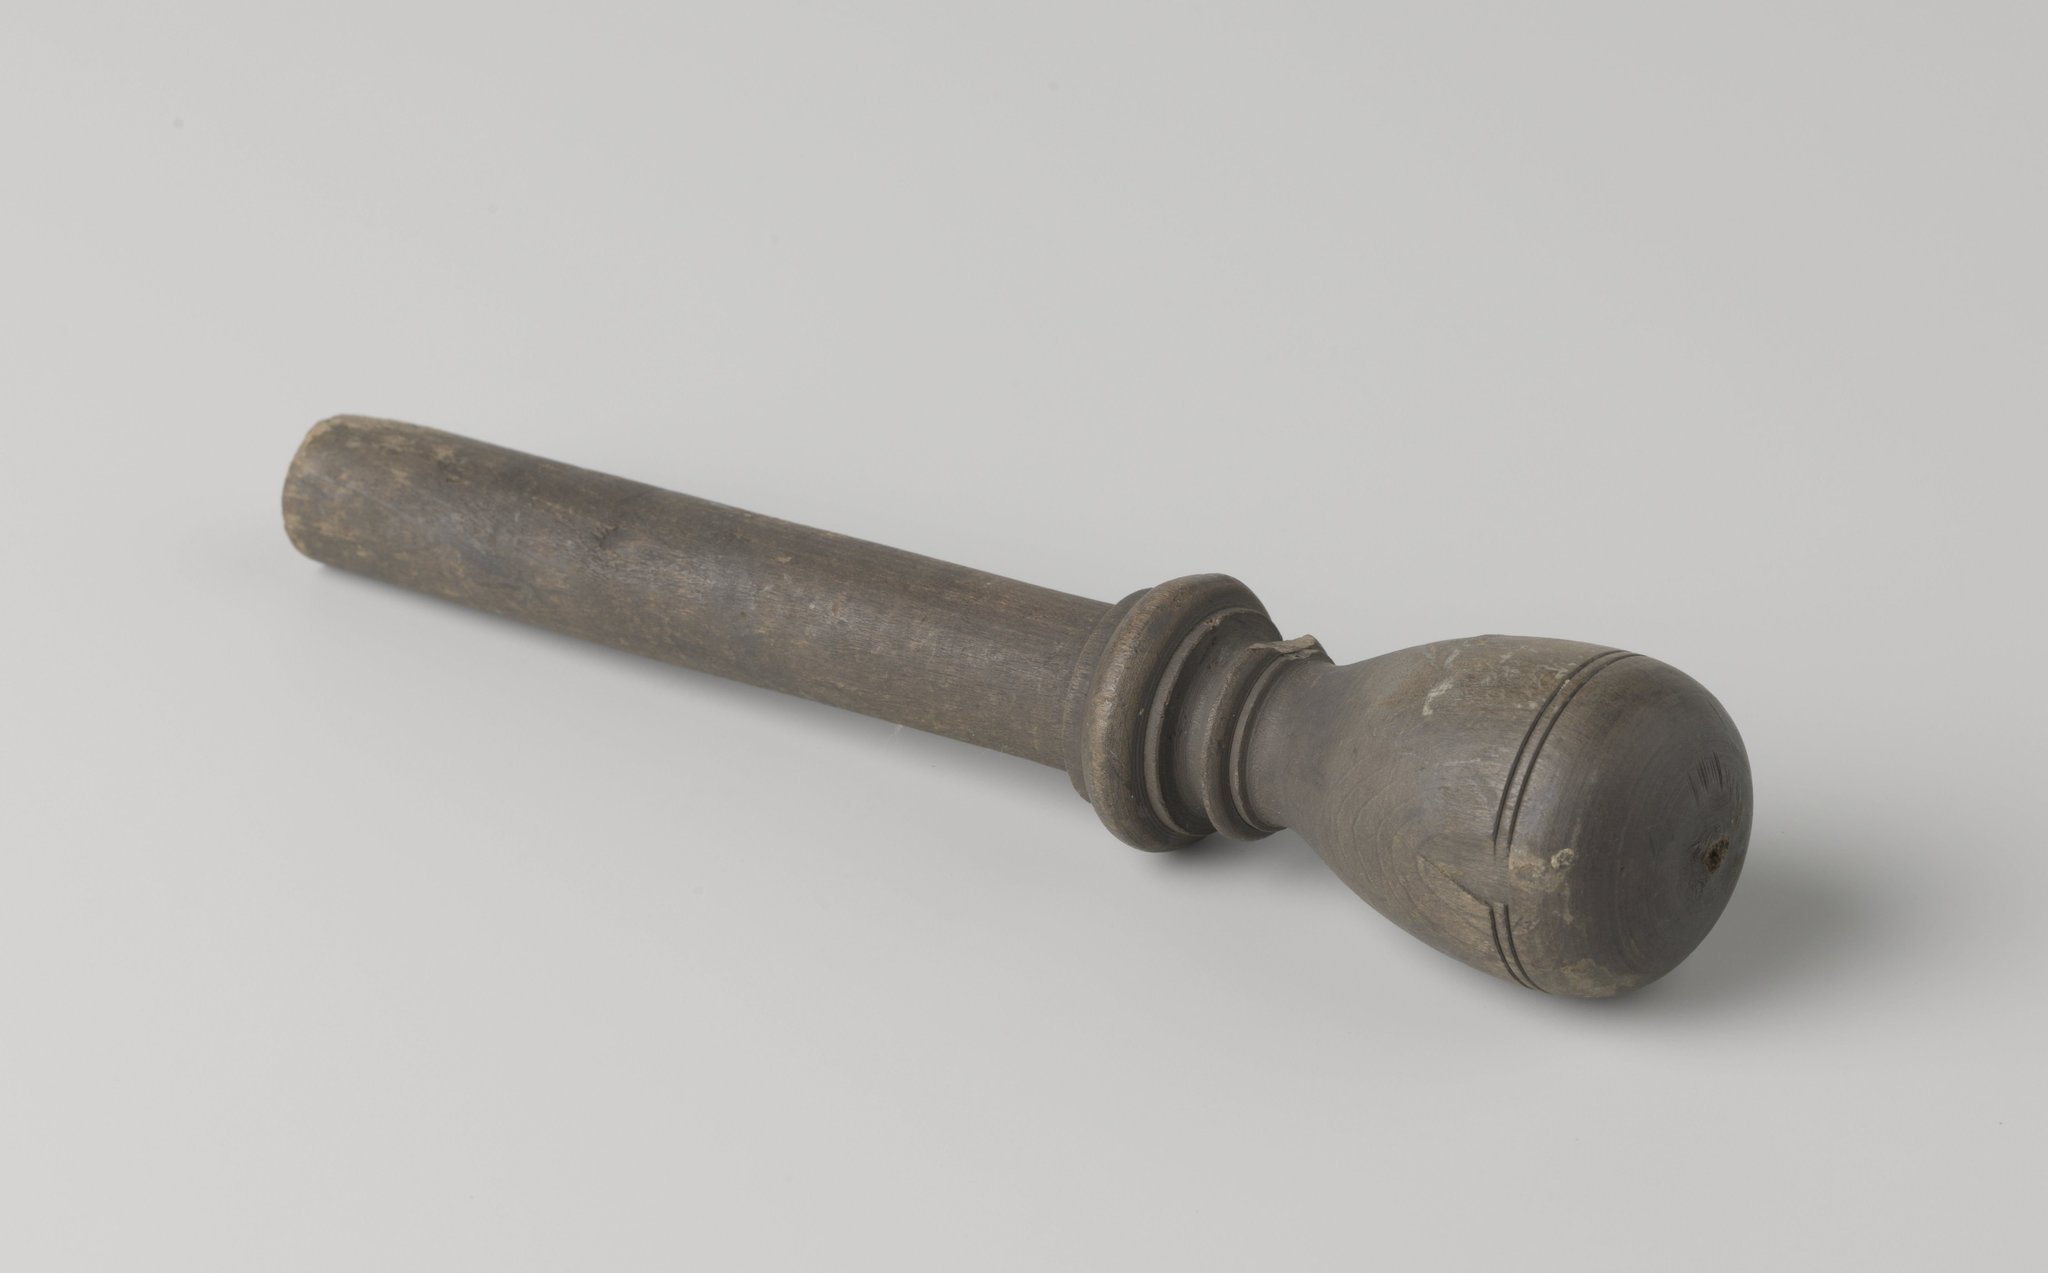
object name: belaying pin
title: Nagel van hout met ronde knop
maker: Anonymous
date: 1590-1596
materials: wood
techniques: turning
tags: willem barendsz., amsterdam, jacob van heemskerck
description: Scheepsonderdeel, pin van hout met ronde knop, gelijk aan NM-7722-2. Op de nagelbank, welke geplaatst was op de railing van het schip en voorzien was van een aantal gaten, konden de korvijnagels gestoken worden, op deze kon het lopend want belegd worden. De korvijnagels konden ook bevestigd zijn op de knecht achter de mast, de middellijn van de korvijnagel was dezelfde als die van de touwen die er aan vastgemaakt werden.